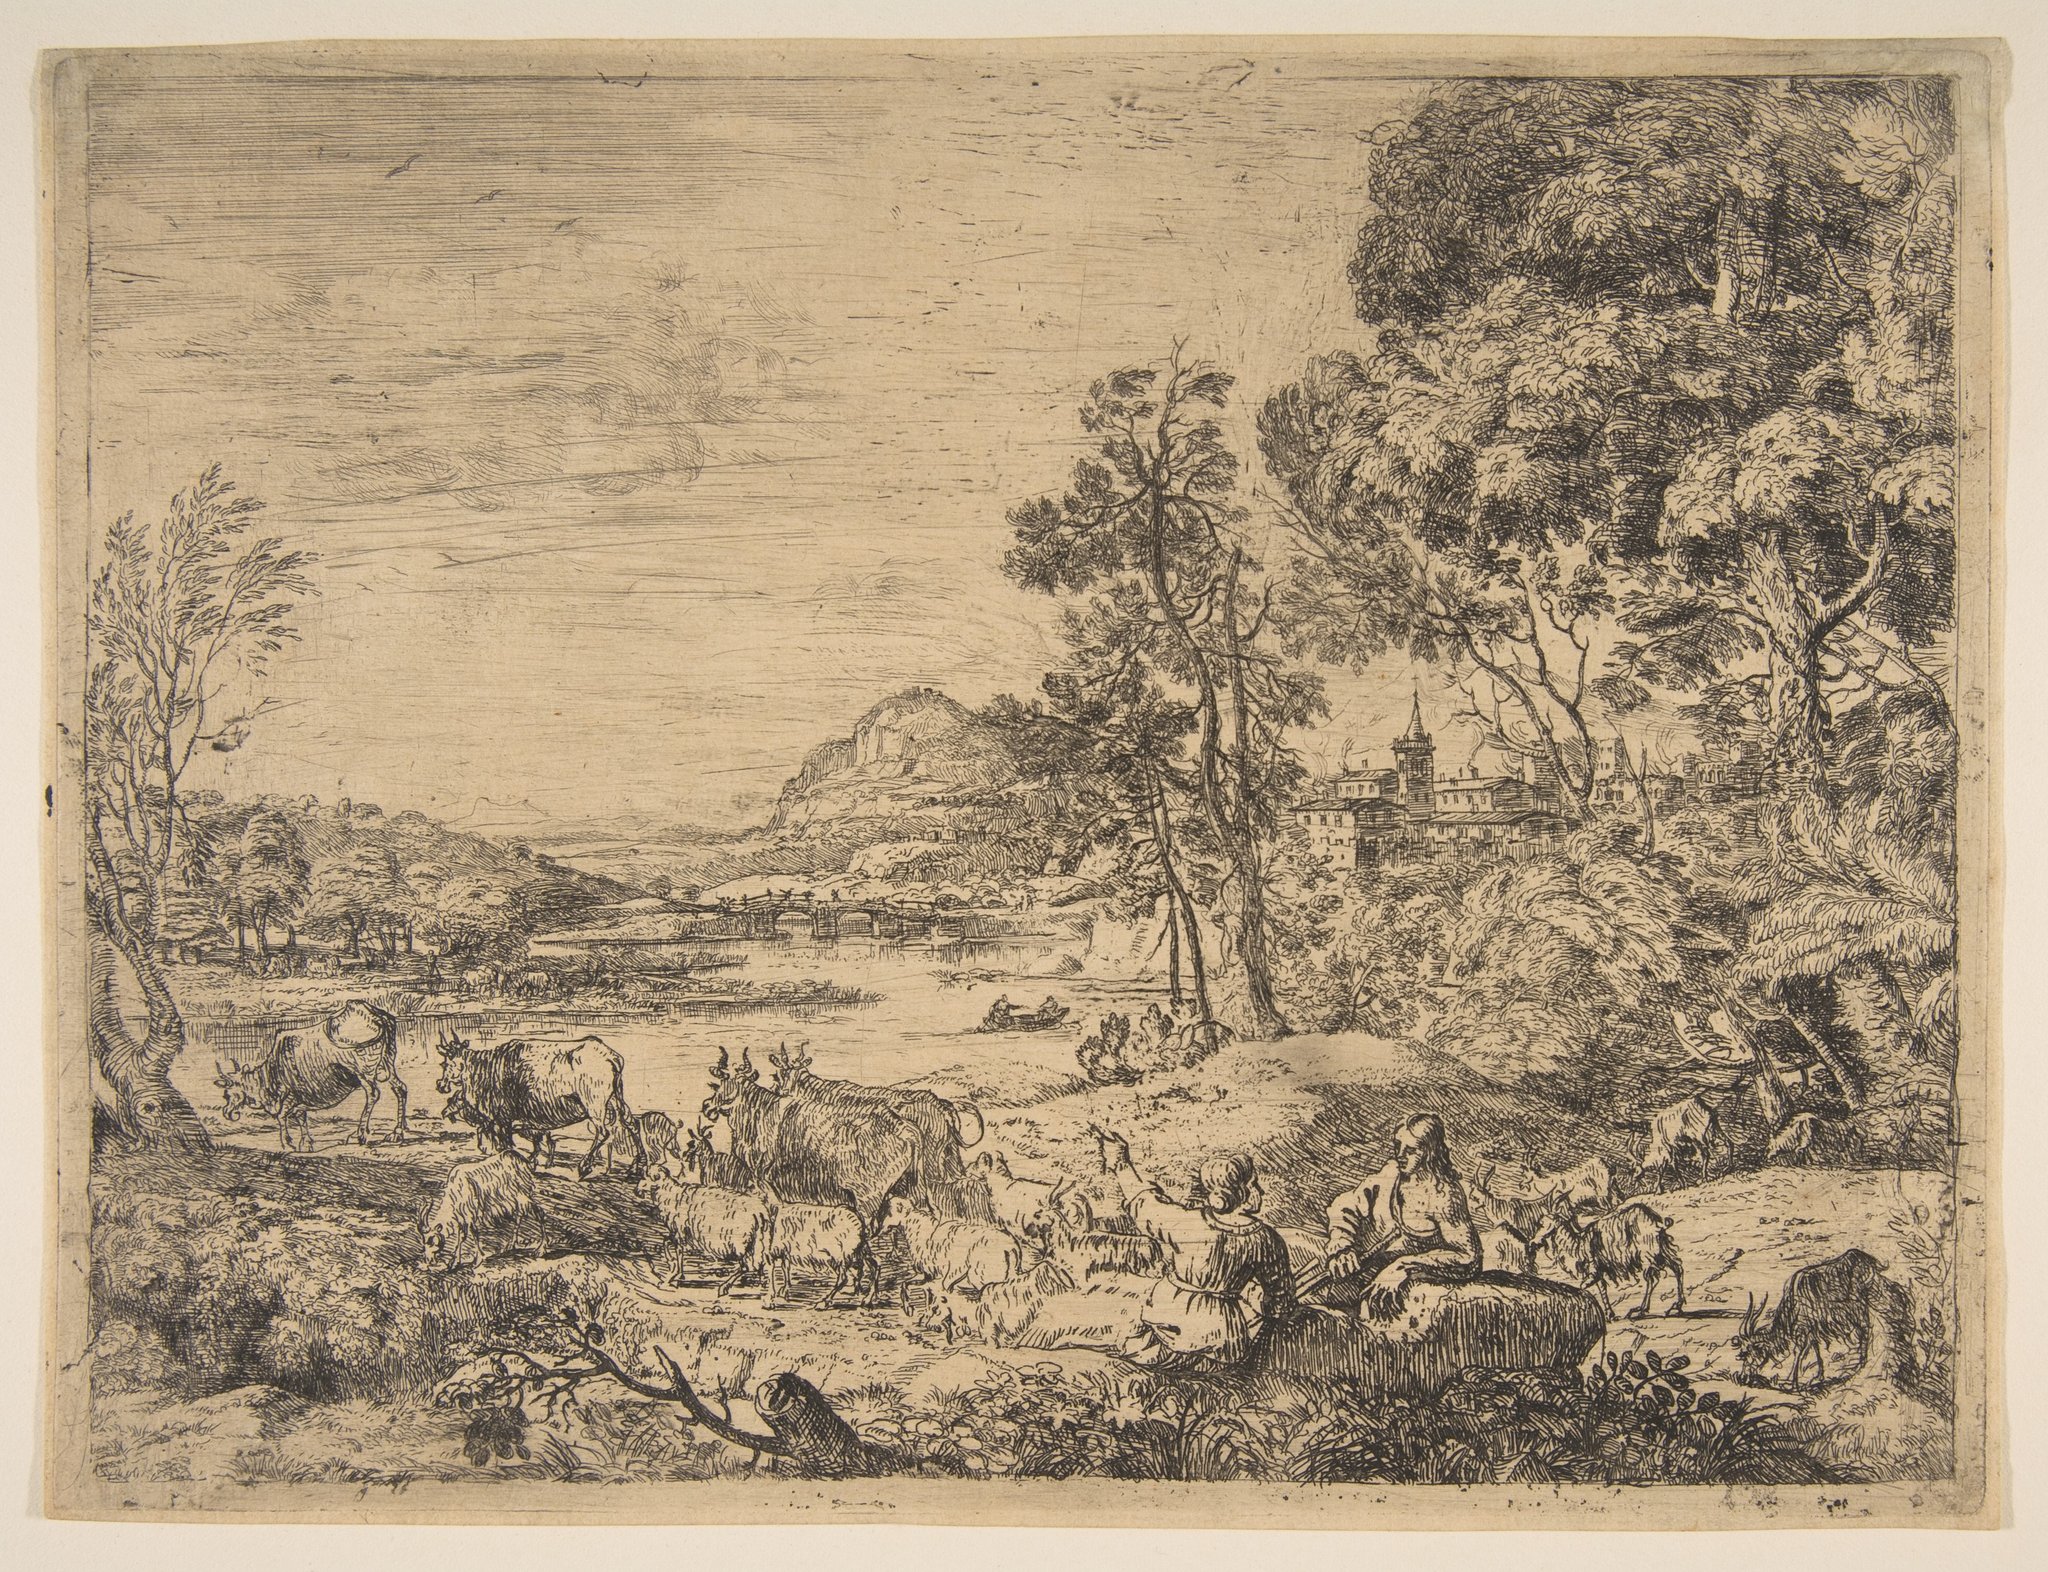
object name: print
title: Shepherd and Shepherdess Conversing in a Landscape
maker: claude lorrain (claude gellée)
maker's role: artist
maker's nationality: french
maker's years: 1604-1682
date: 1651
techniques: etching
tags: animals,women,landscapes,trees,shepherds